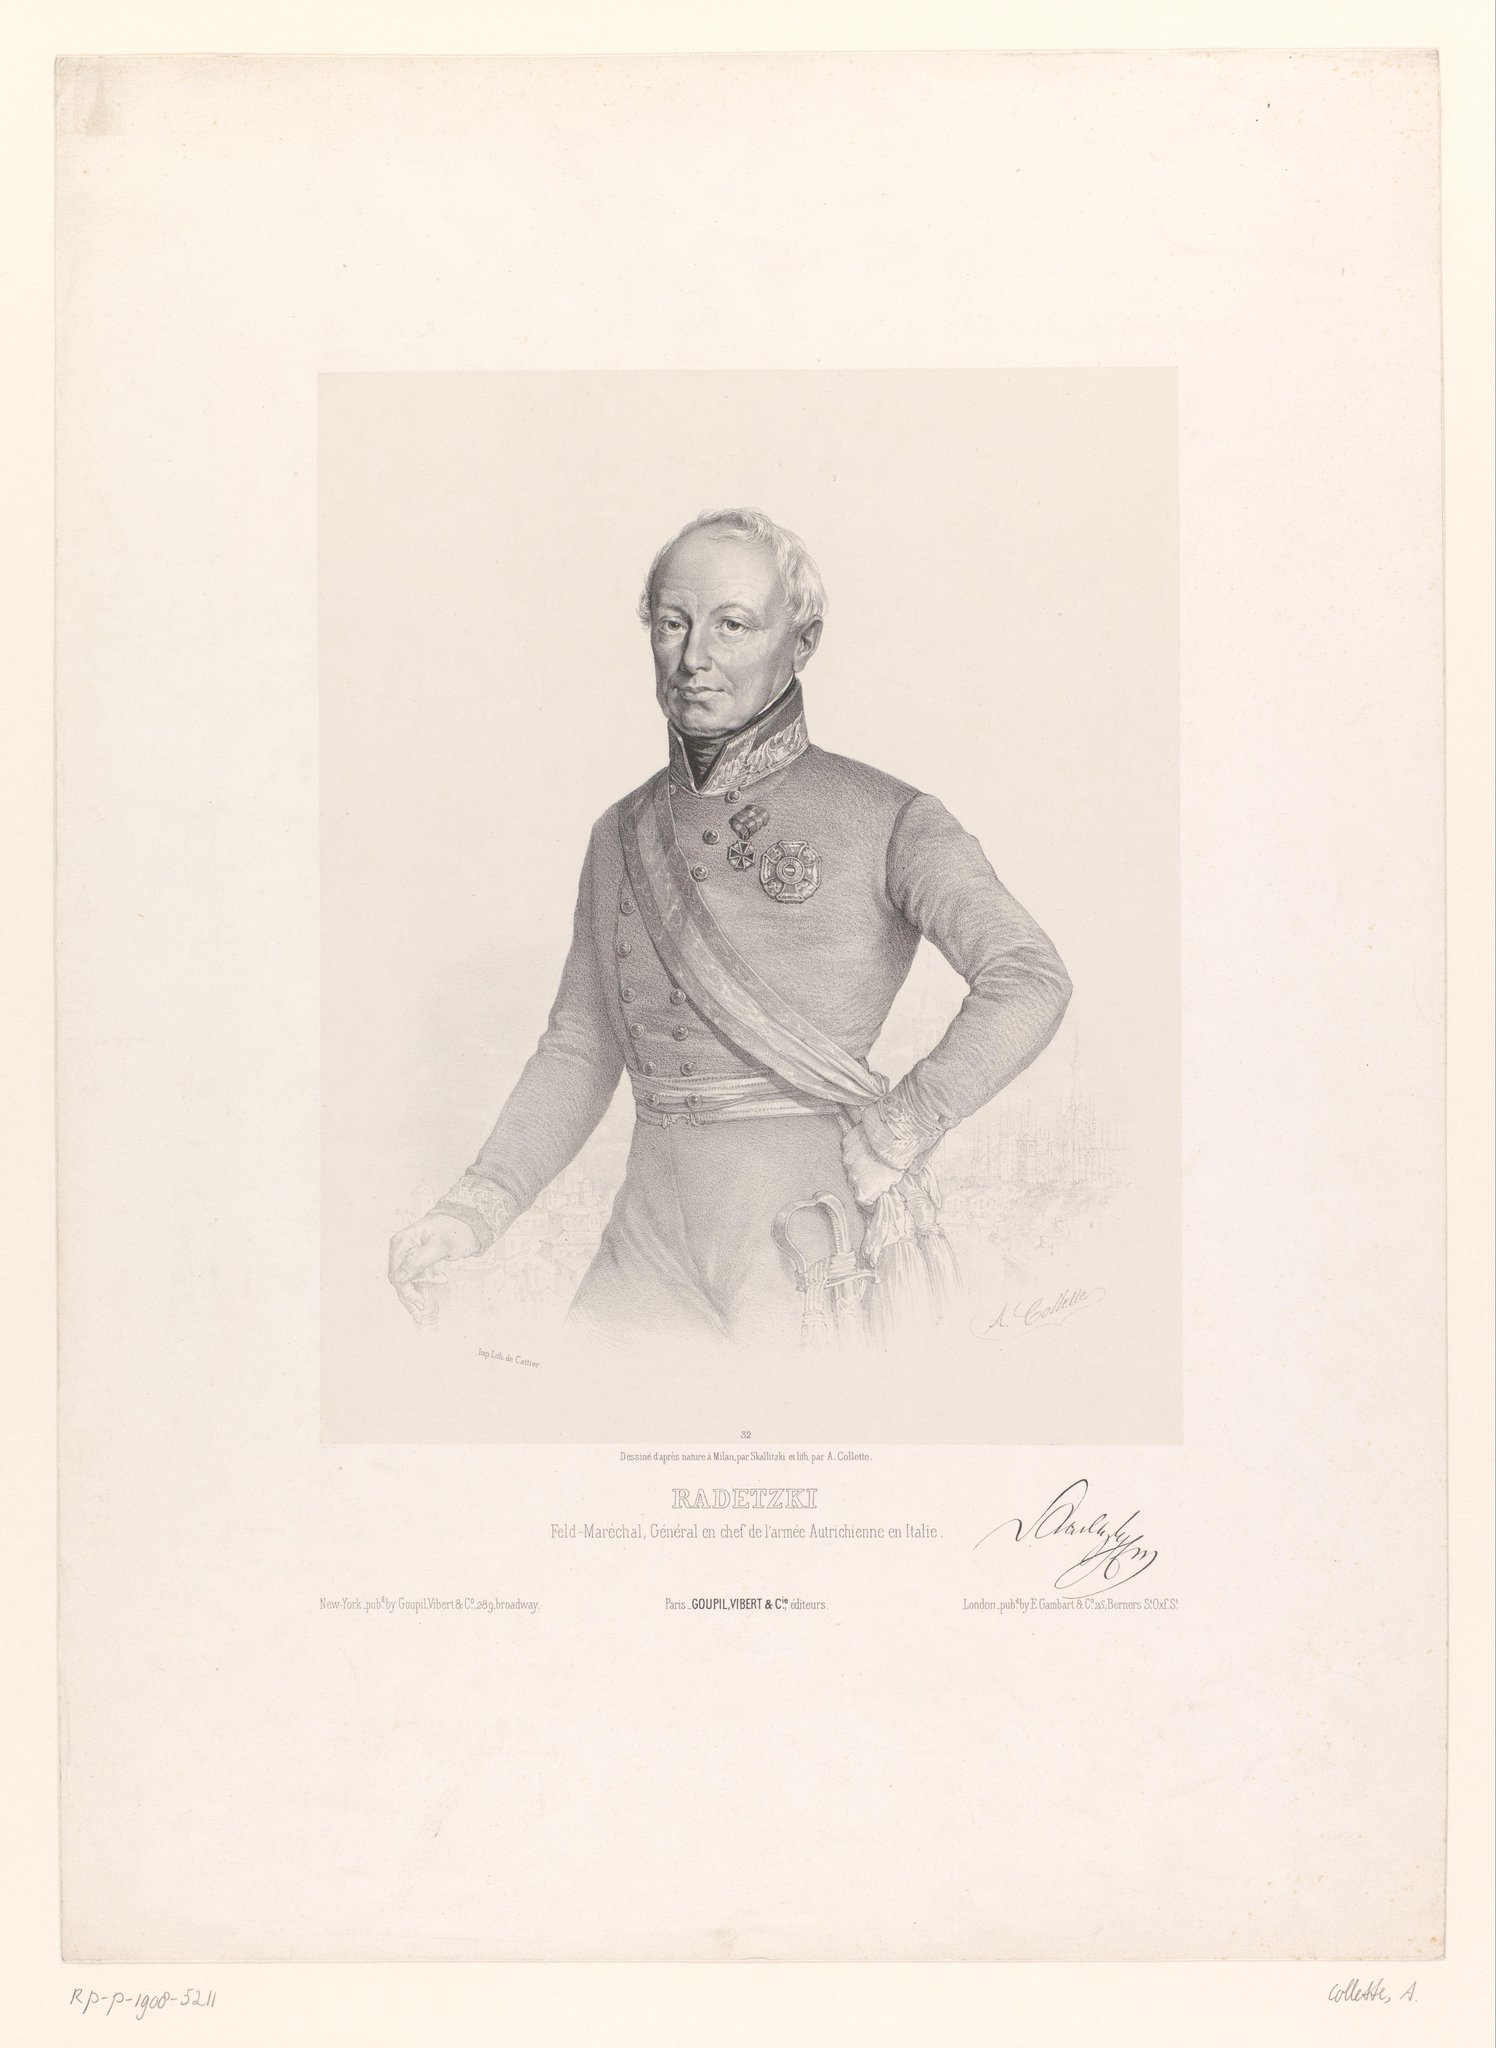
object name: print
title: Radetzki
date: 1849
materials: paper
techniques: lithograph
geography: paris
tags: historical persons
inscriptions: check stamp: Lugt 5004, collector's mark: Lugt 2228a